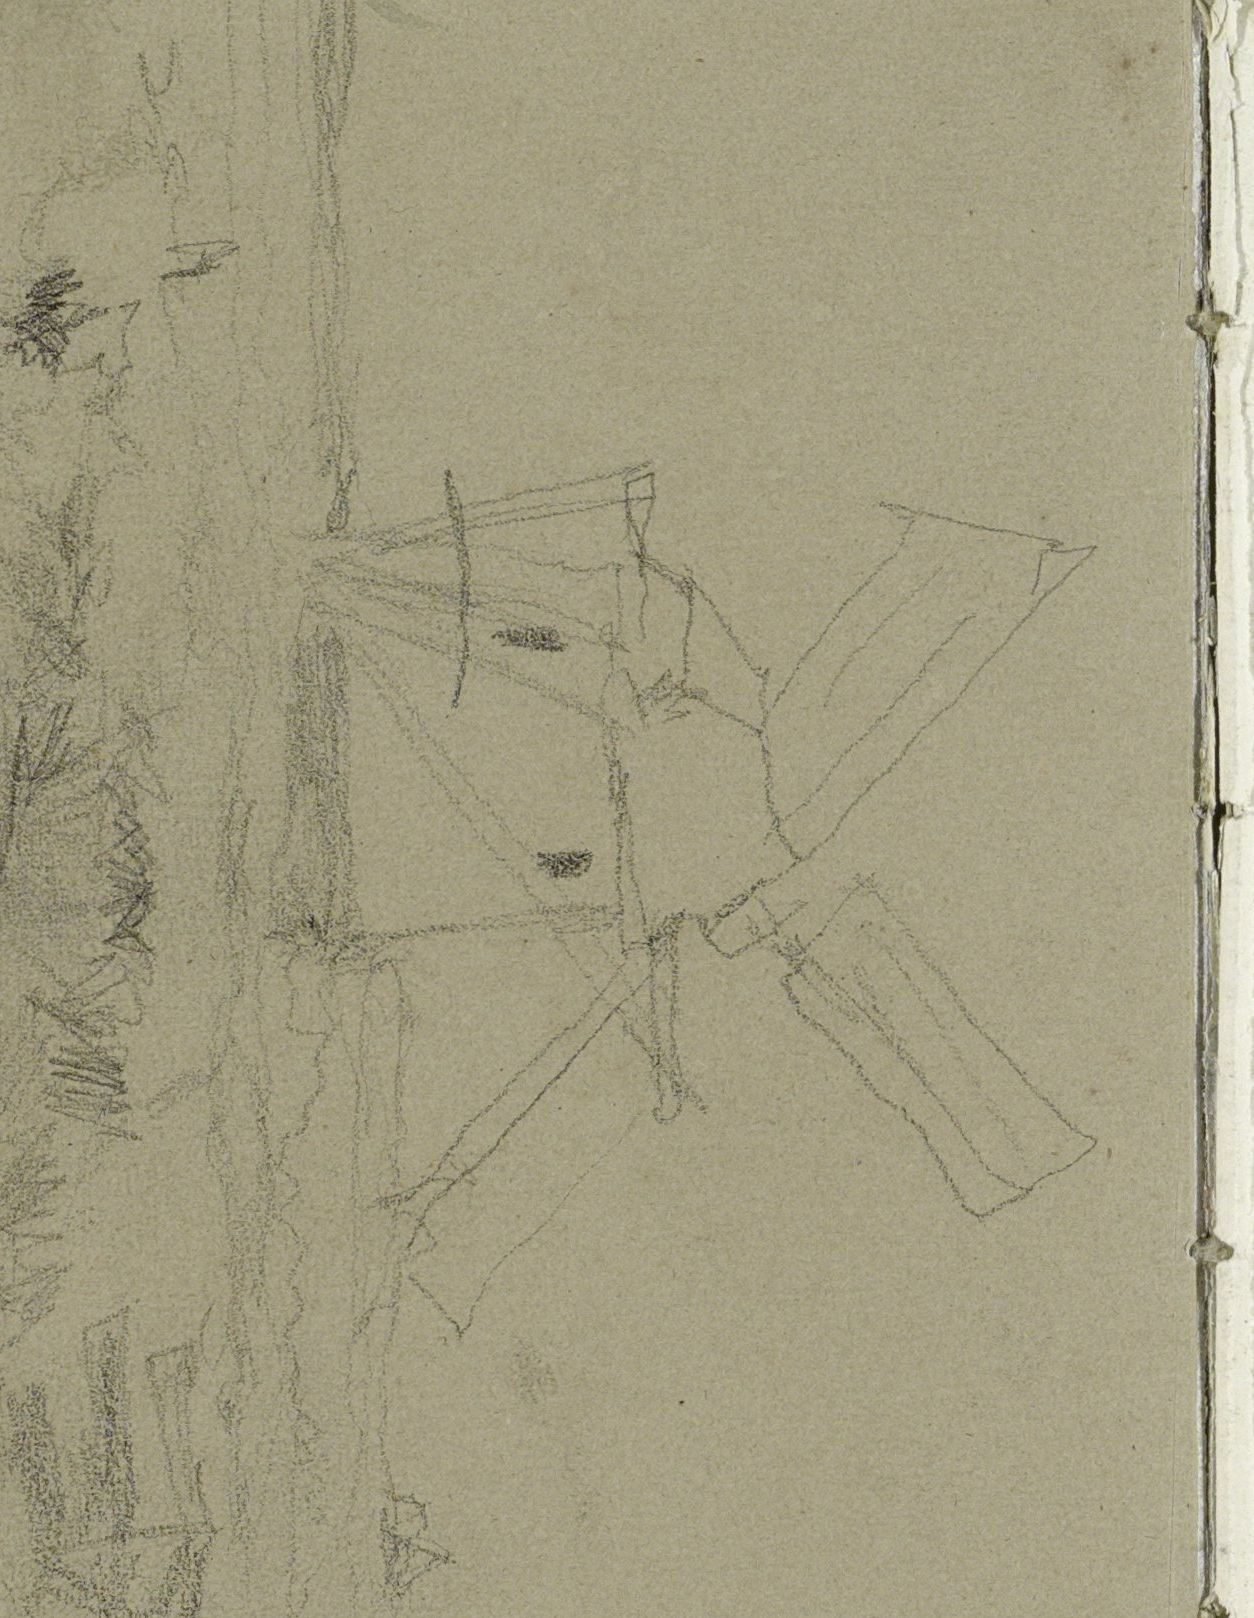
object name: sketchbook leaf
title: Molen in een landschap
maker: johan hendrik weissenbruch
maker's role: draughtsman, painter, print maker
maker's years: 1824-1903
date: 1834-1903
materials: paper, pencil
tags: windmill in landscape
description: Blad 34 verso uit een schetsboek met 34 bladen.